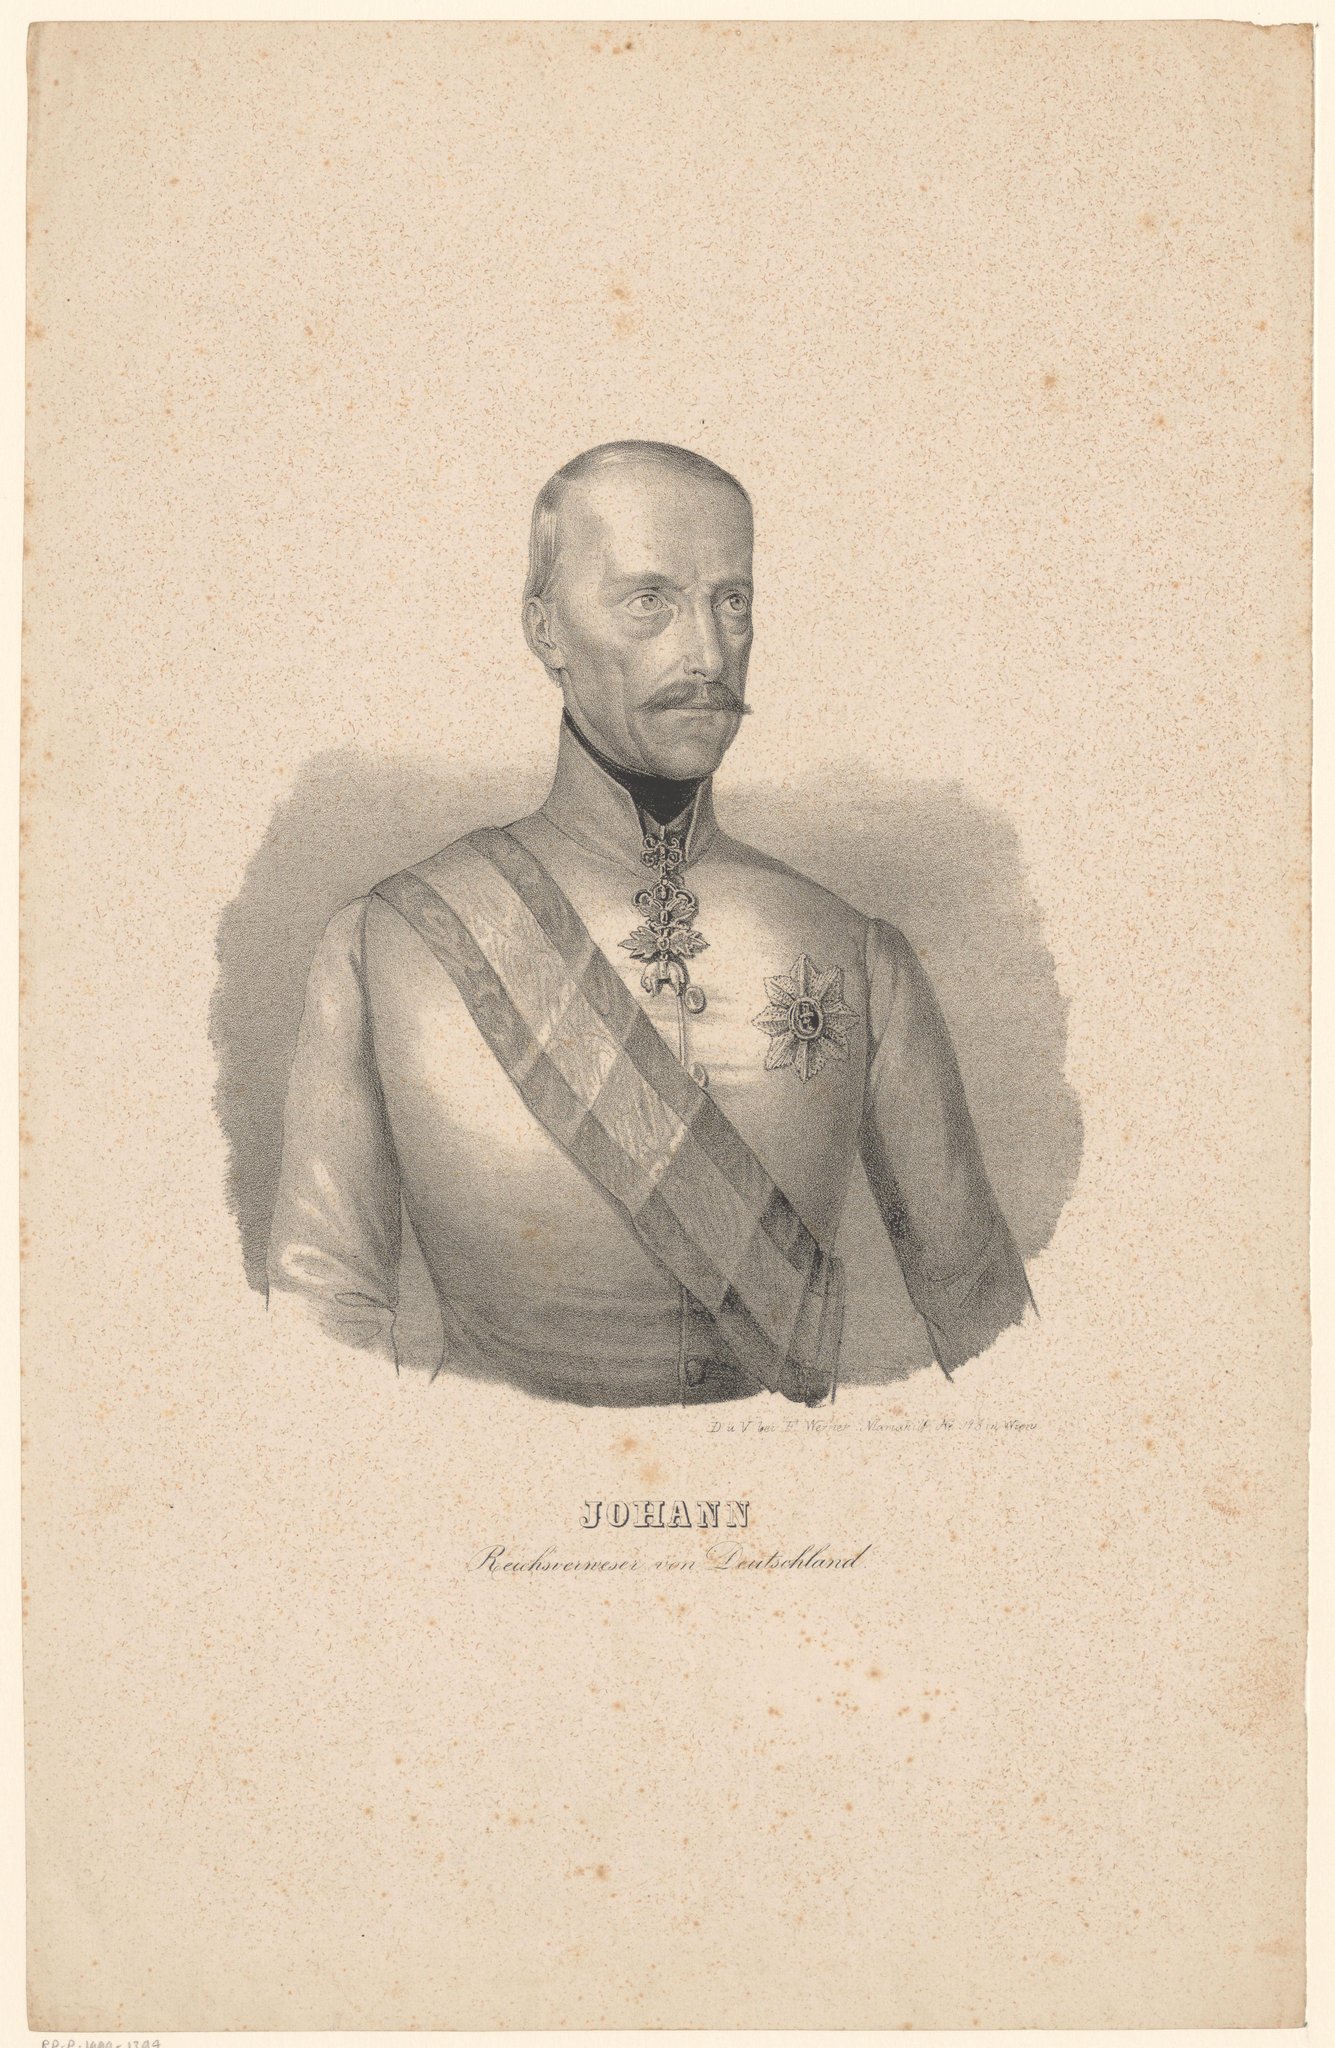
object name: print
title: Portret van Johann, aartshertog van Oostenrijk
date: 1848-1860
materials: paper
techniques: lithograph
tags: adult man, historical persons, knighthood order of the golden fleece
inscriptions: collector's mark: Lugt 2228, collector's mark: Lugt 2760, inscription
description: Portret ten halve lijve, naar rechts, in uniform, met ordetekens op de borst en sjerp om.